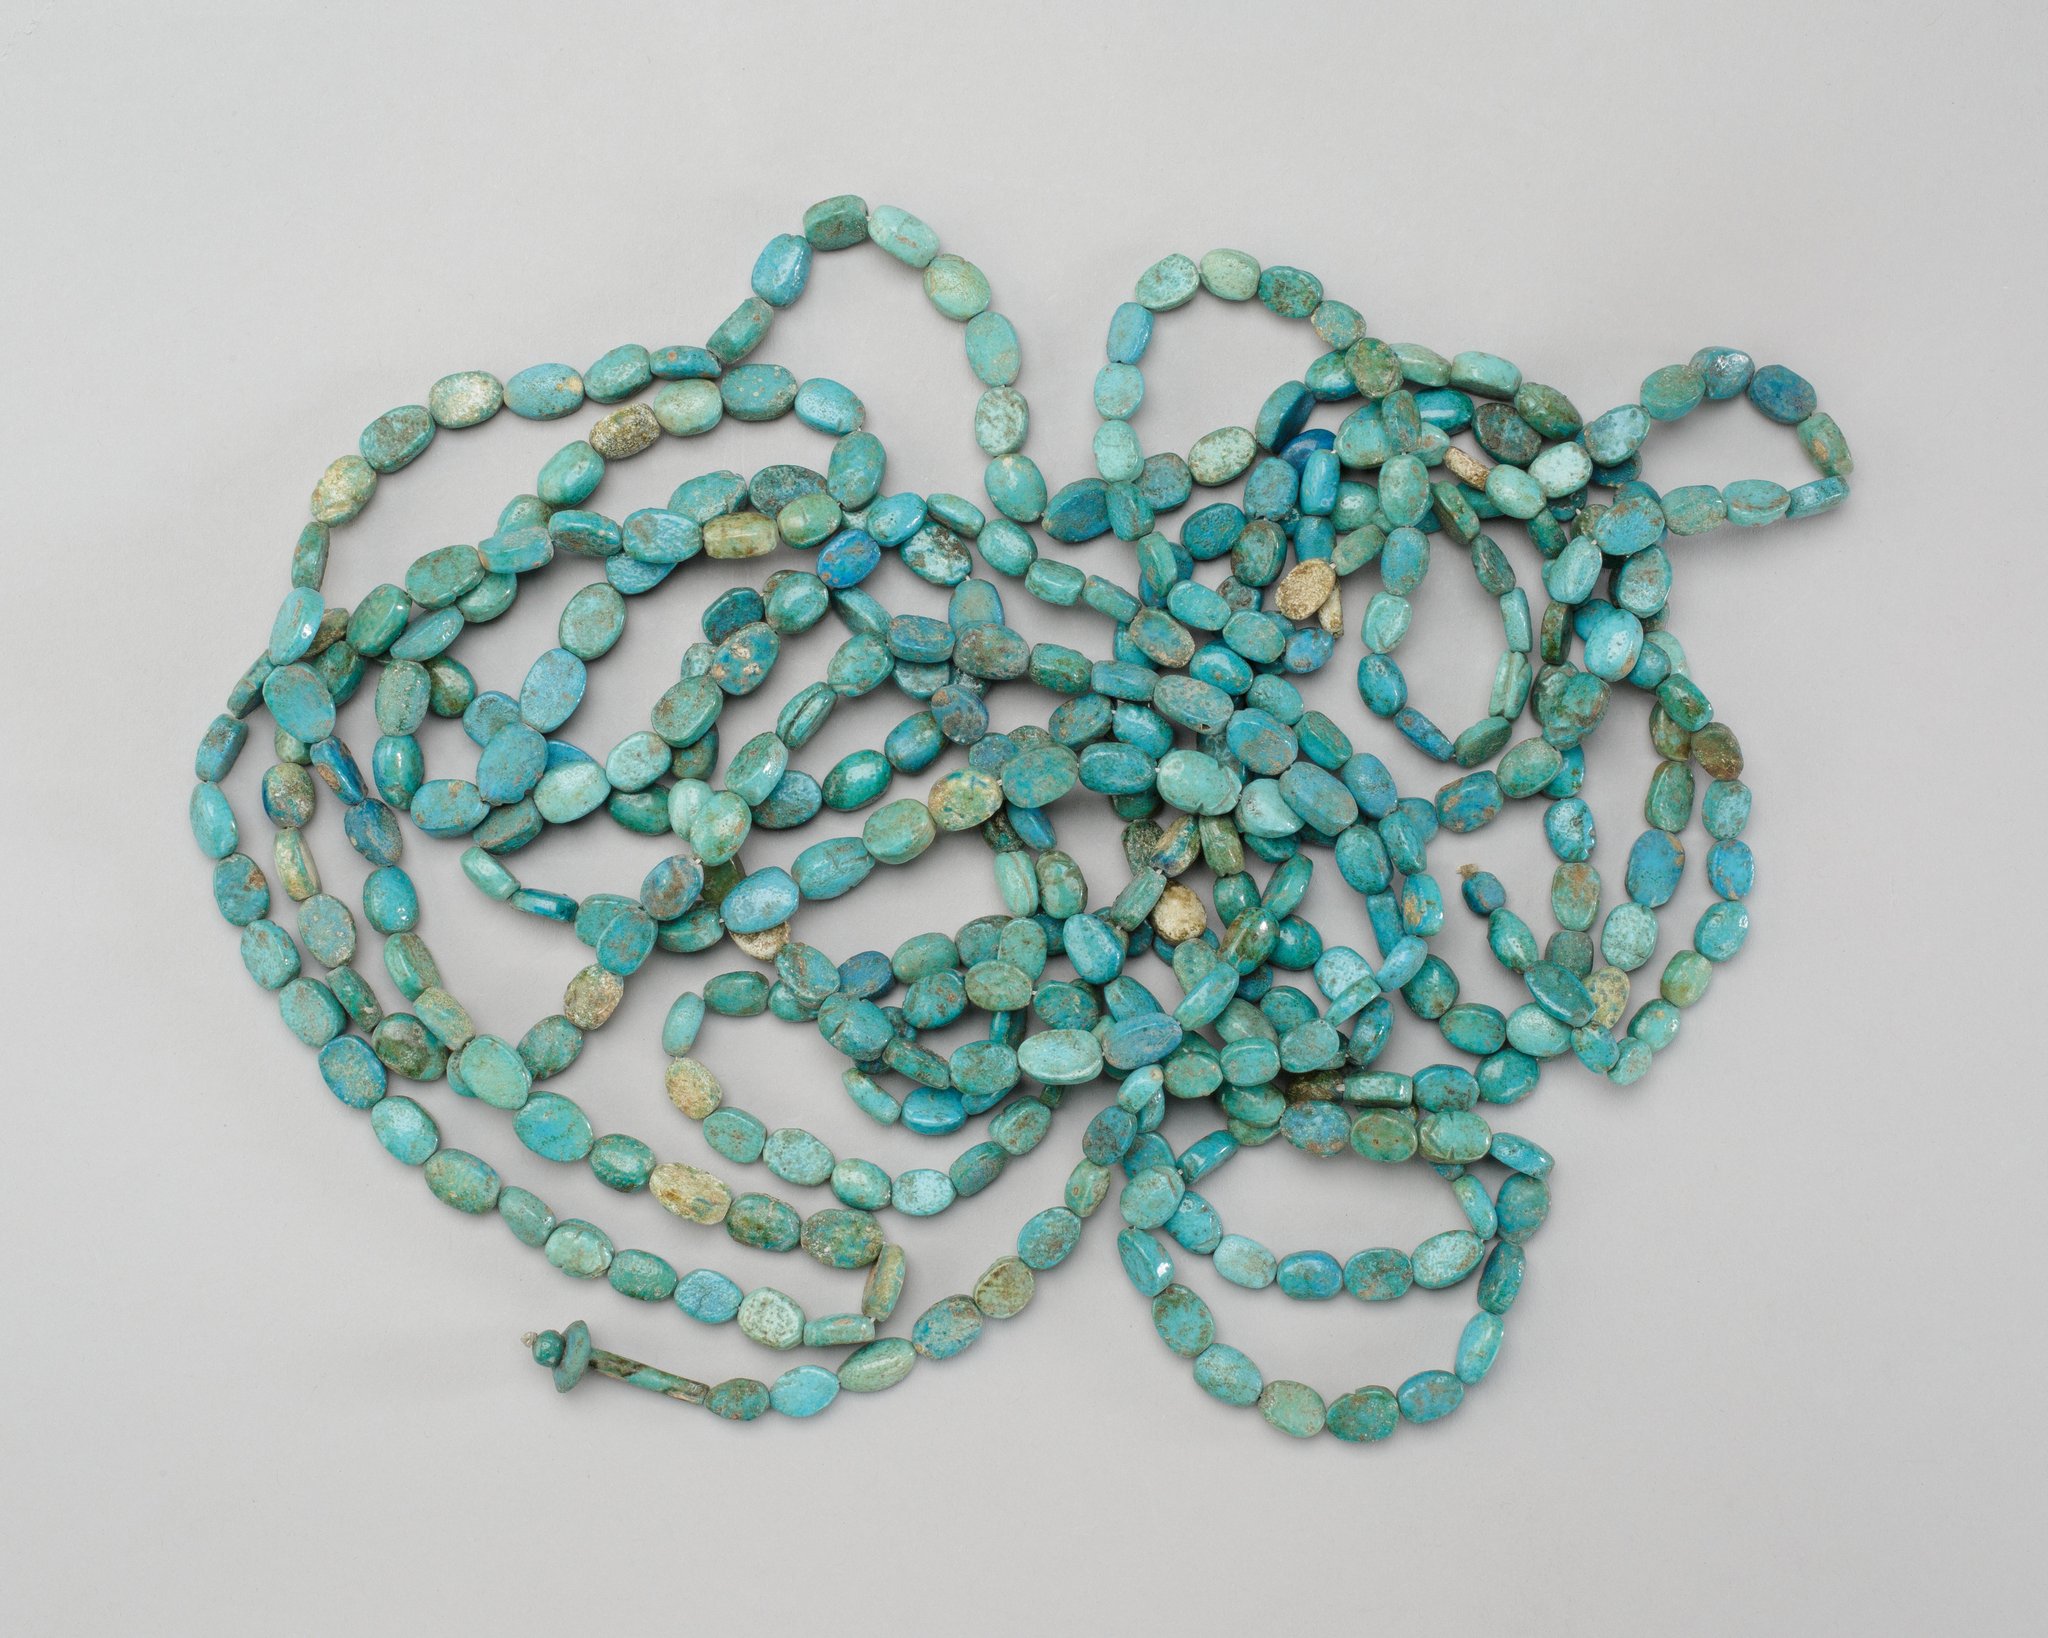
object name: bead, scarab, amenemhat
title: Strand of Scarab and Scaraboid Beads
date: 1504-1447 BCE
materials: faience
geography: egypt